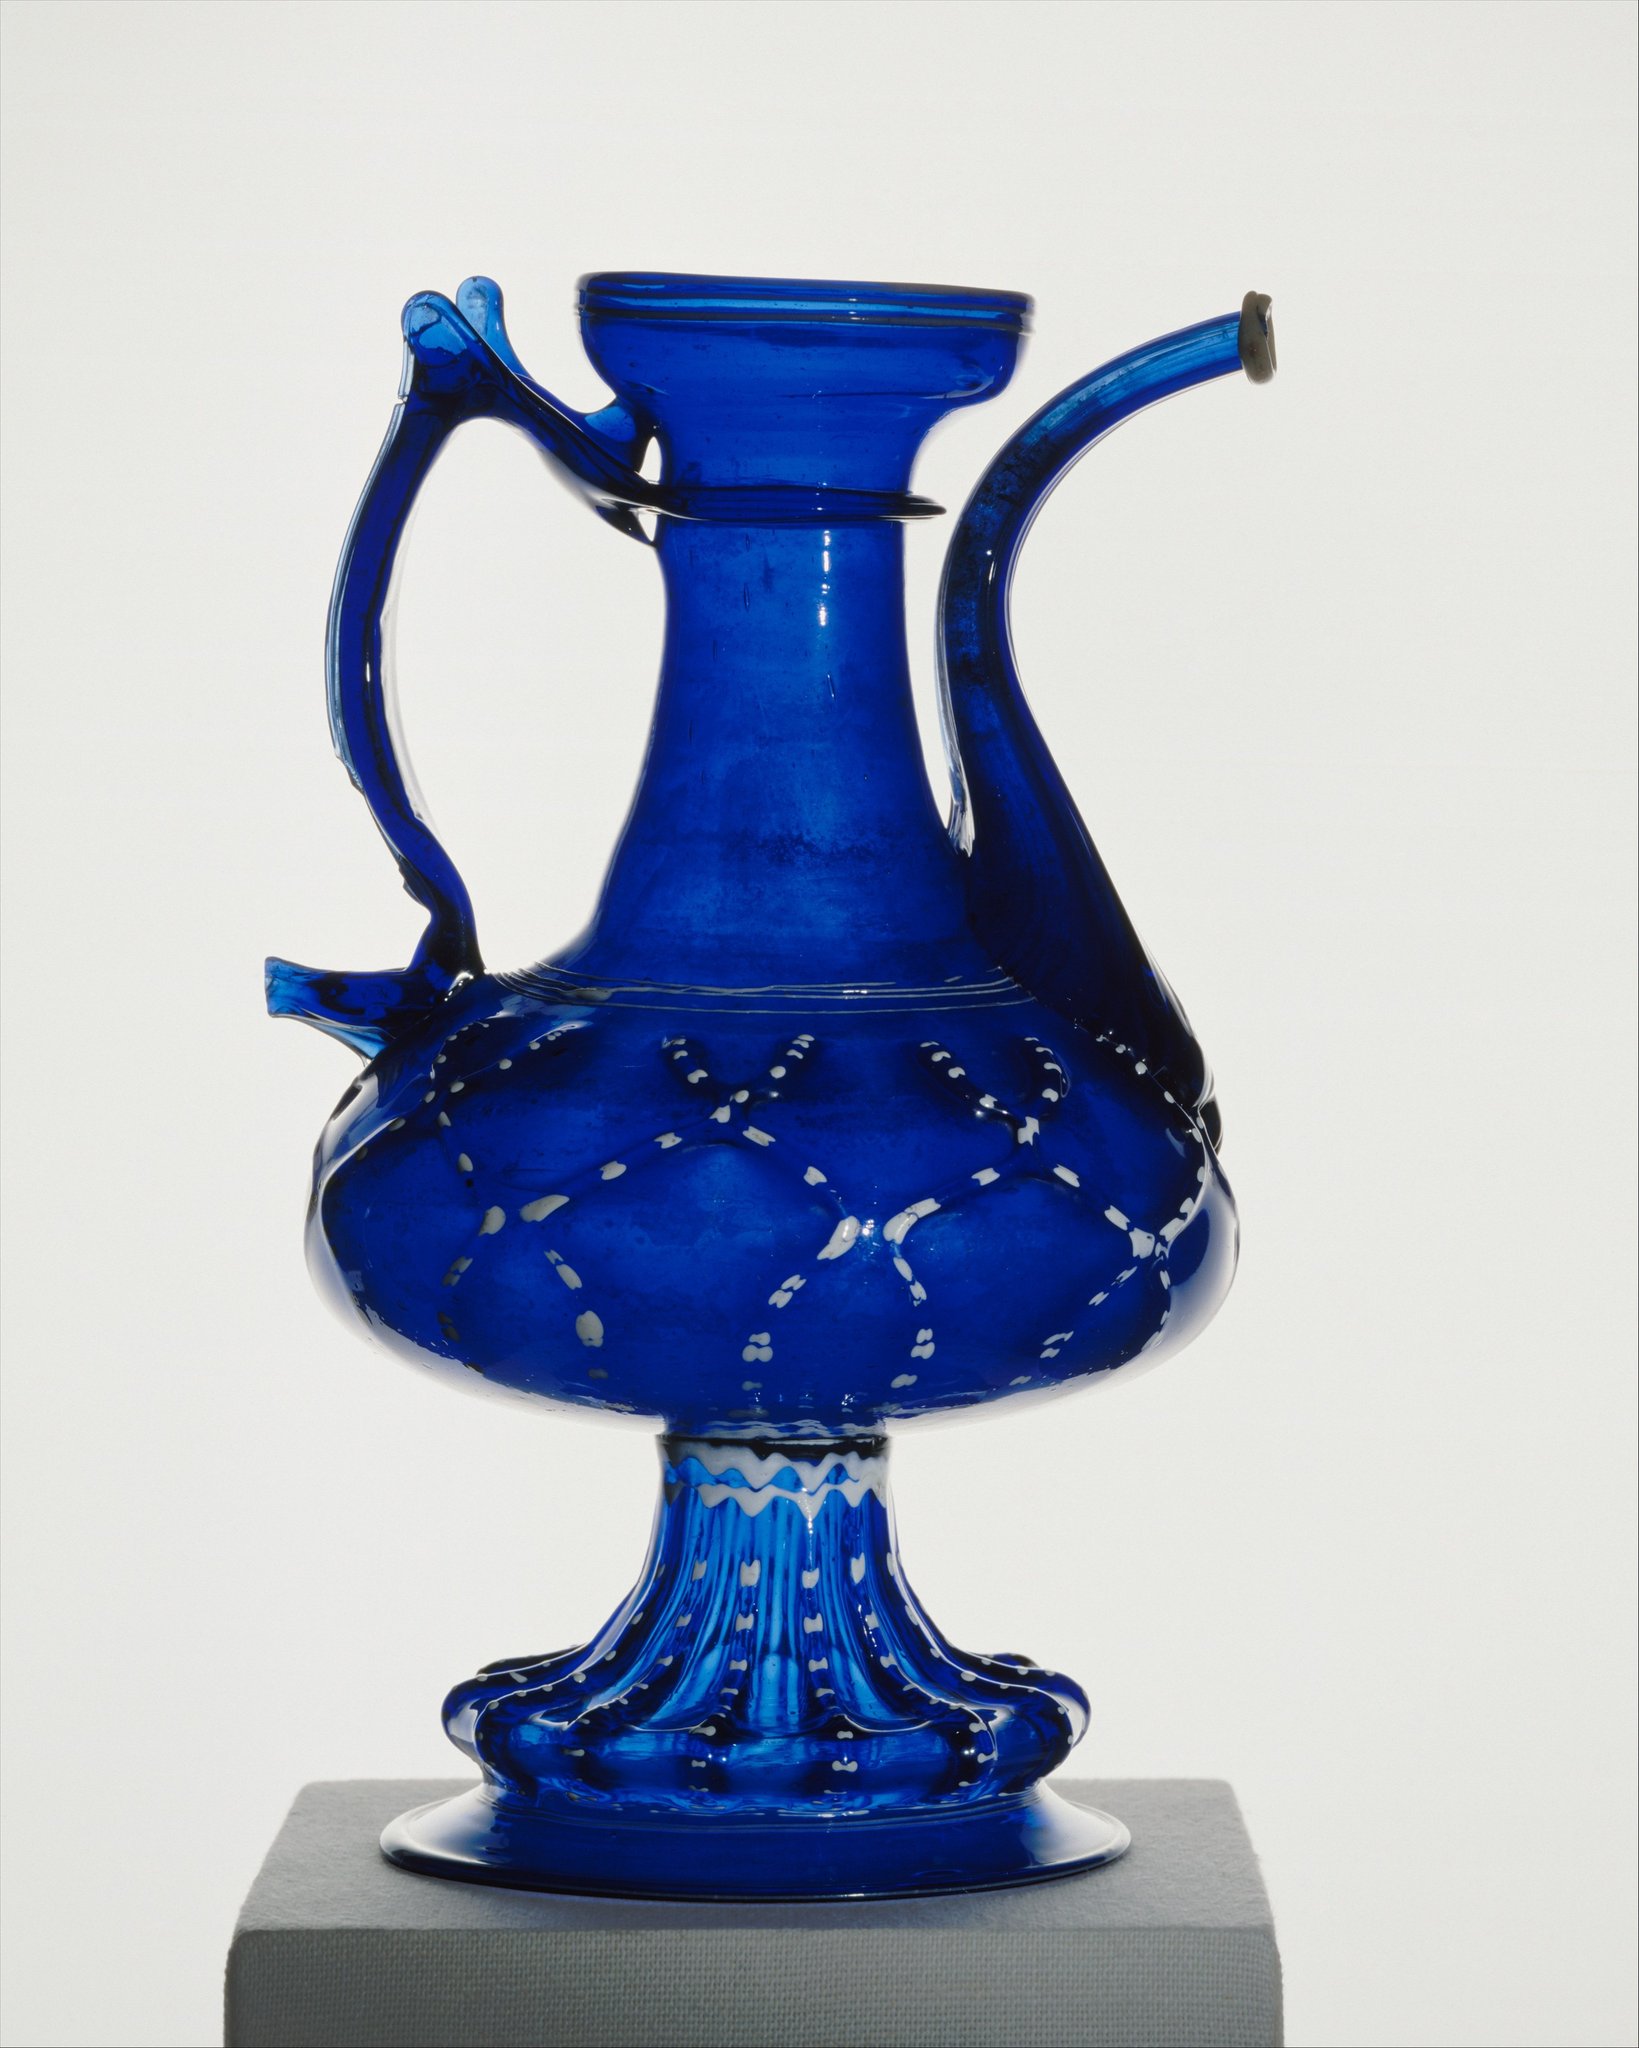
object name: jug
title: Spouted jug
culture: façon de venise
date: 1500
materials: glass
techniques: glassblowing, molding